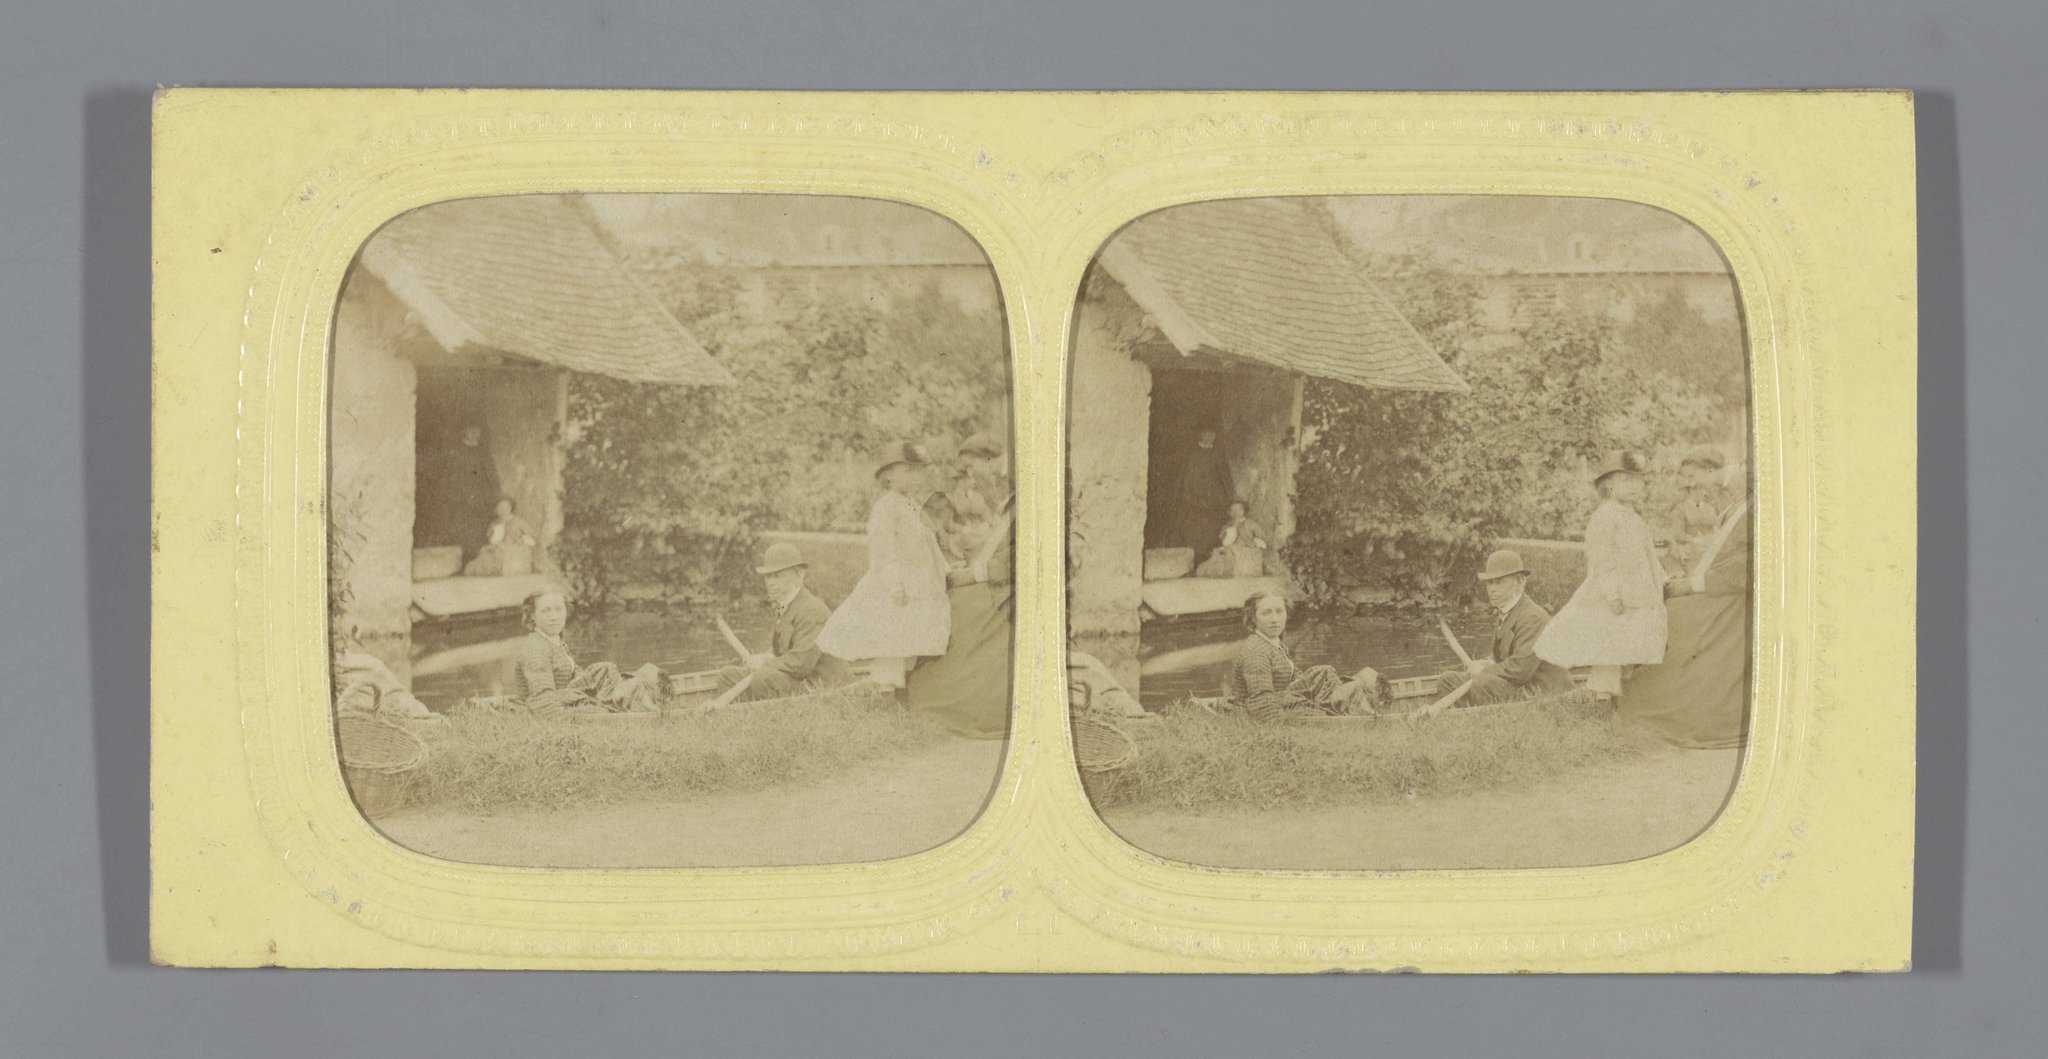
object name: tissue stereograph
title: Paar in boot, op de kade enkele mensen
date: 1855-1875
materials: cardboard, paper, photographic support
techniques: albumen print, hand coloring, perforating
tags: rowing-boat, canoe, etc.